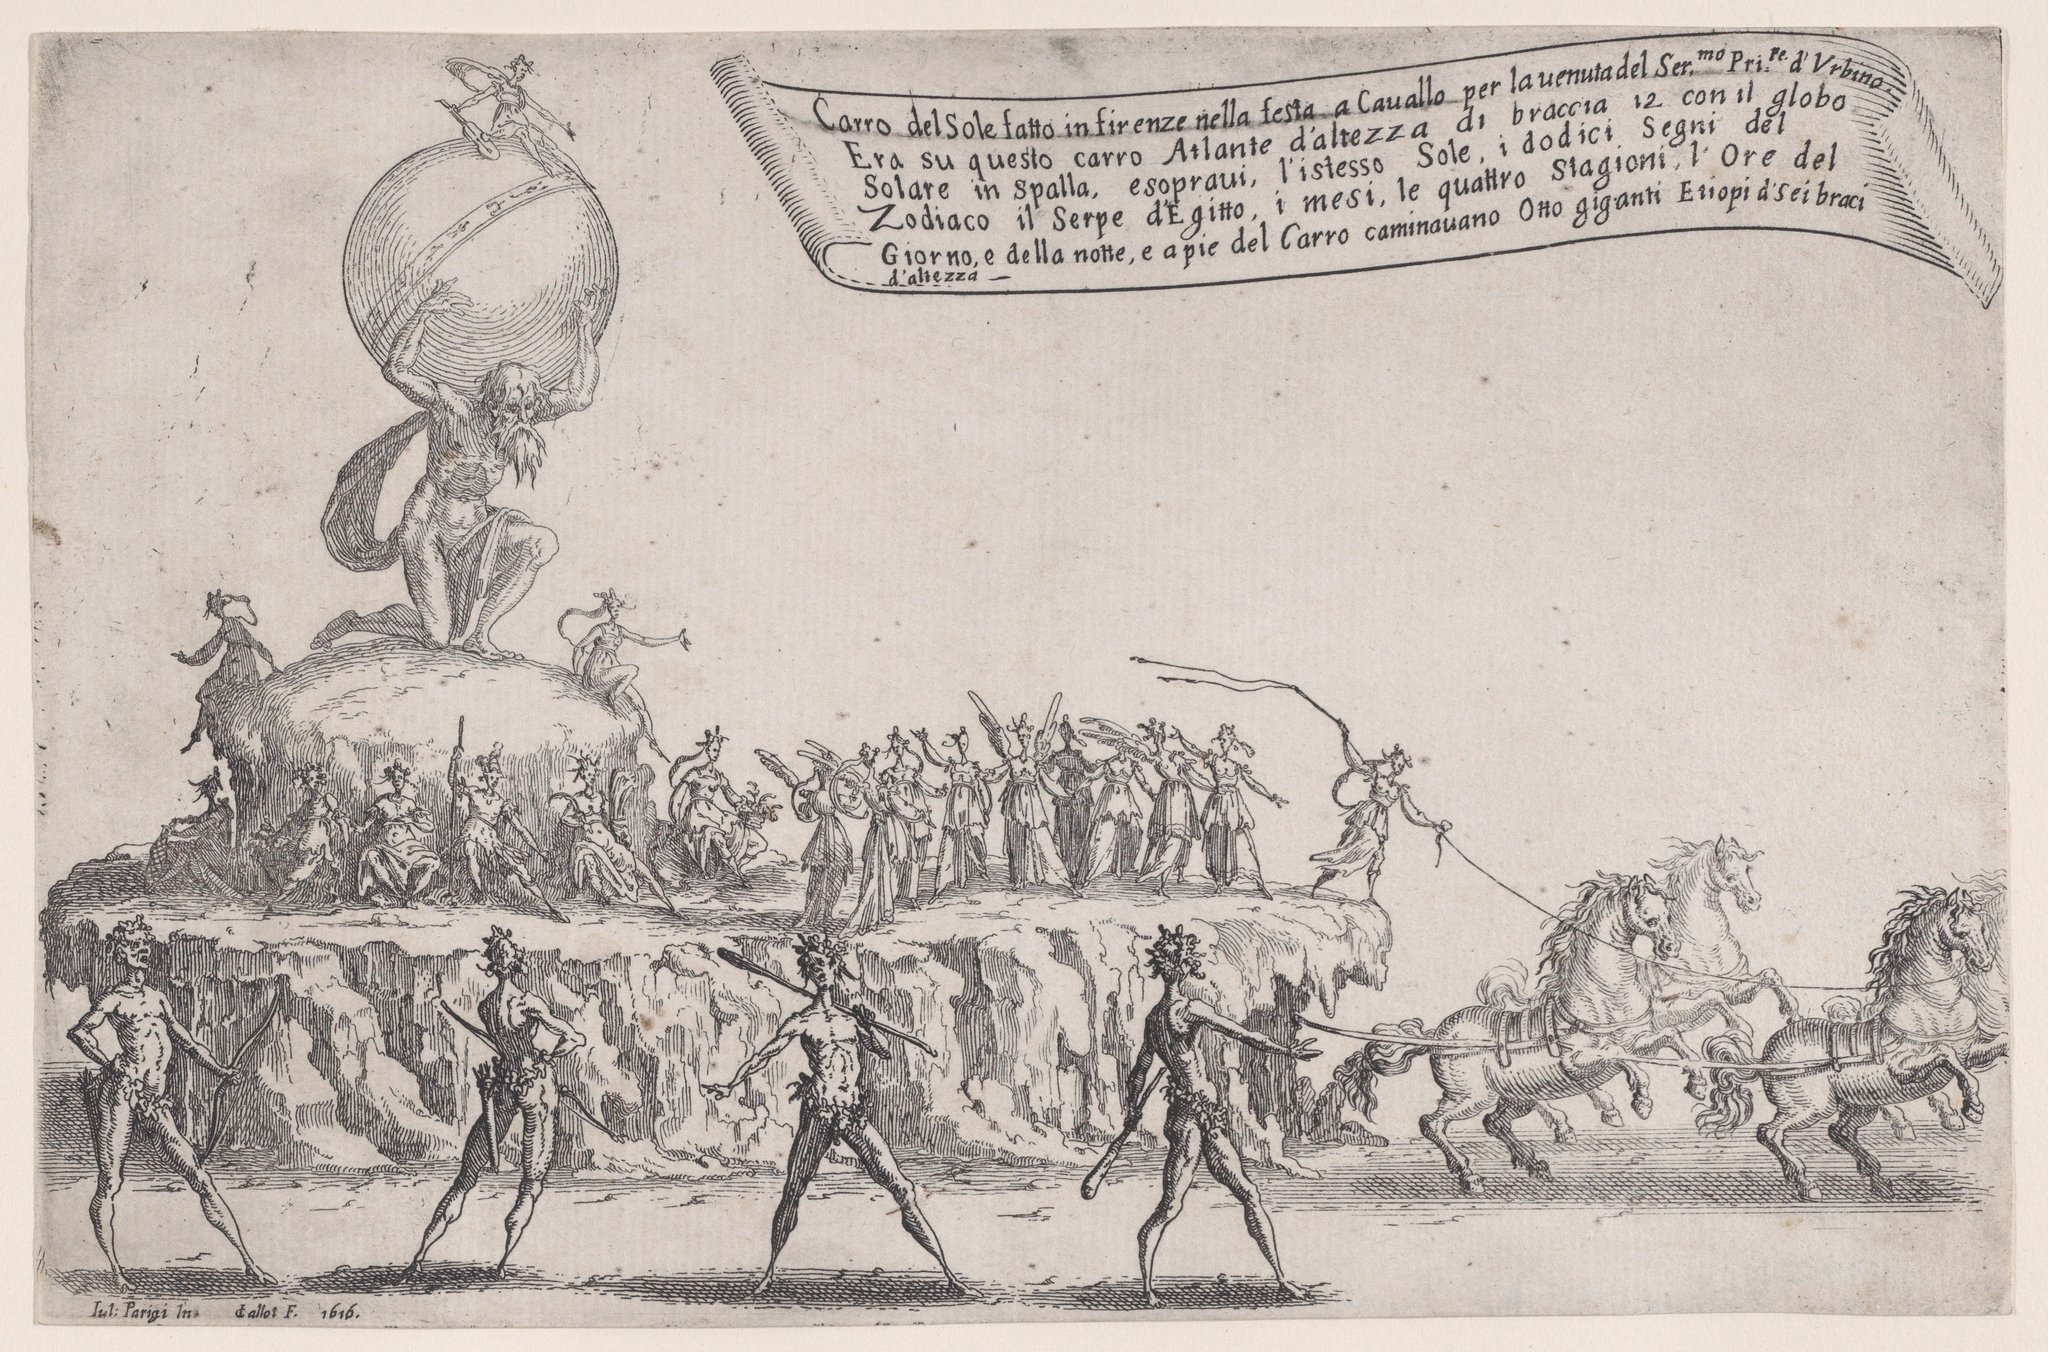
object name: print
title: Le Char du Soleil (The Chariot of Sun), from "Guerre de Beauté" (Guerra di Bellezza) (War of Beauty)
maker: jacques callot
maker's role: artist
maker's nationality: french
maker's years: 1592-1635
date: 1616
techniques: etching